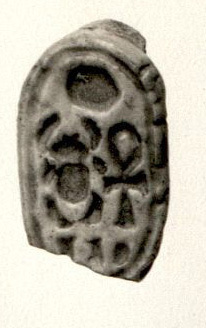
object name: ring bezel, ankhkheperure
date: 1352-1336 BCE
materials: faience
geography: egypt